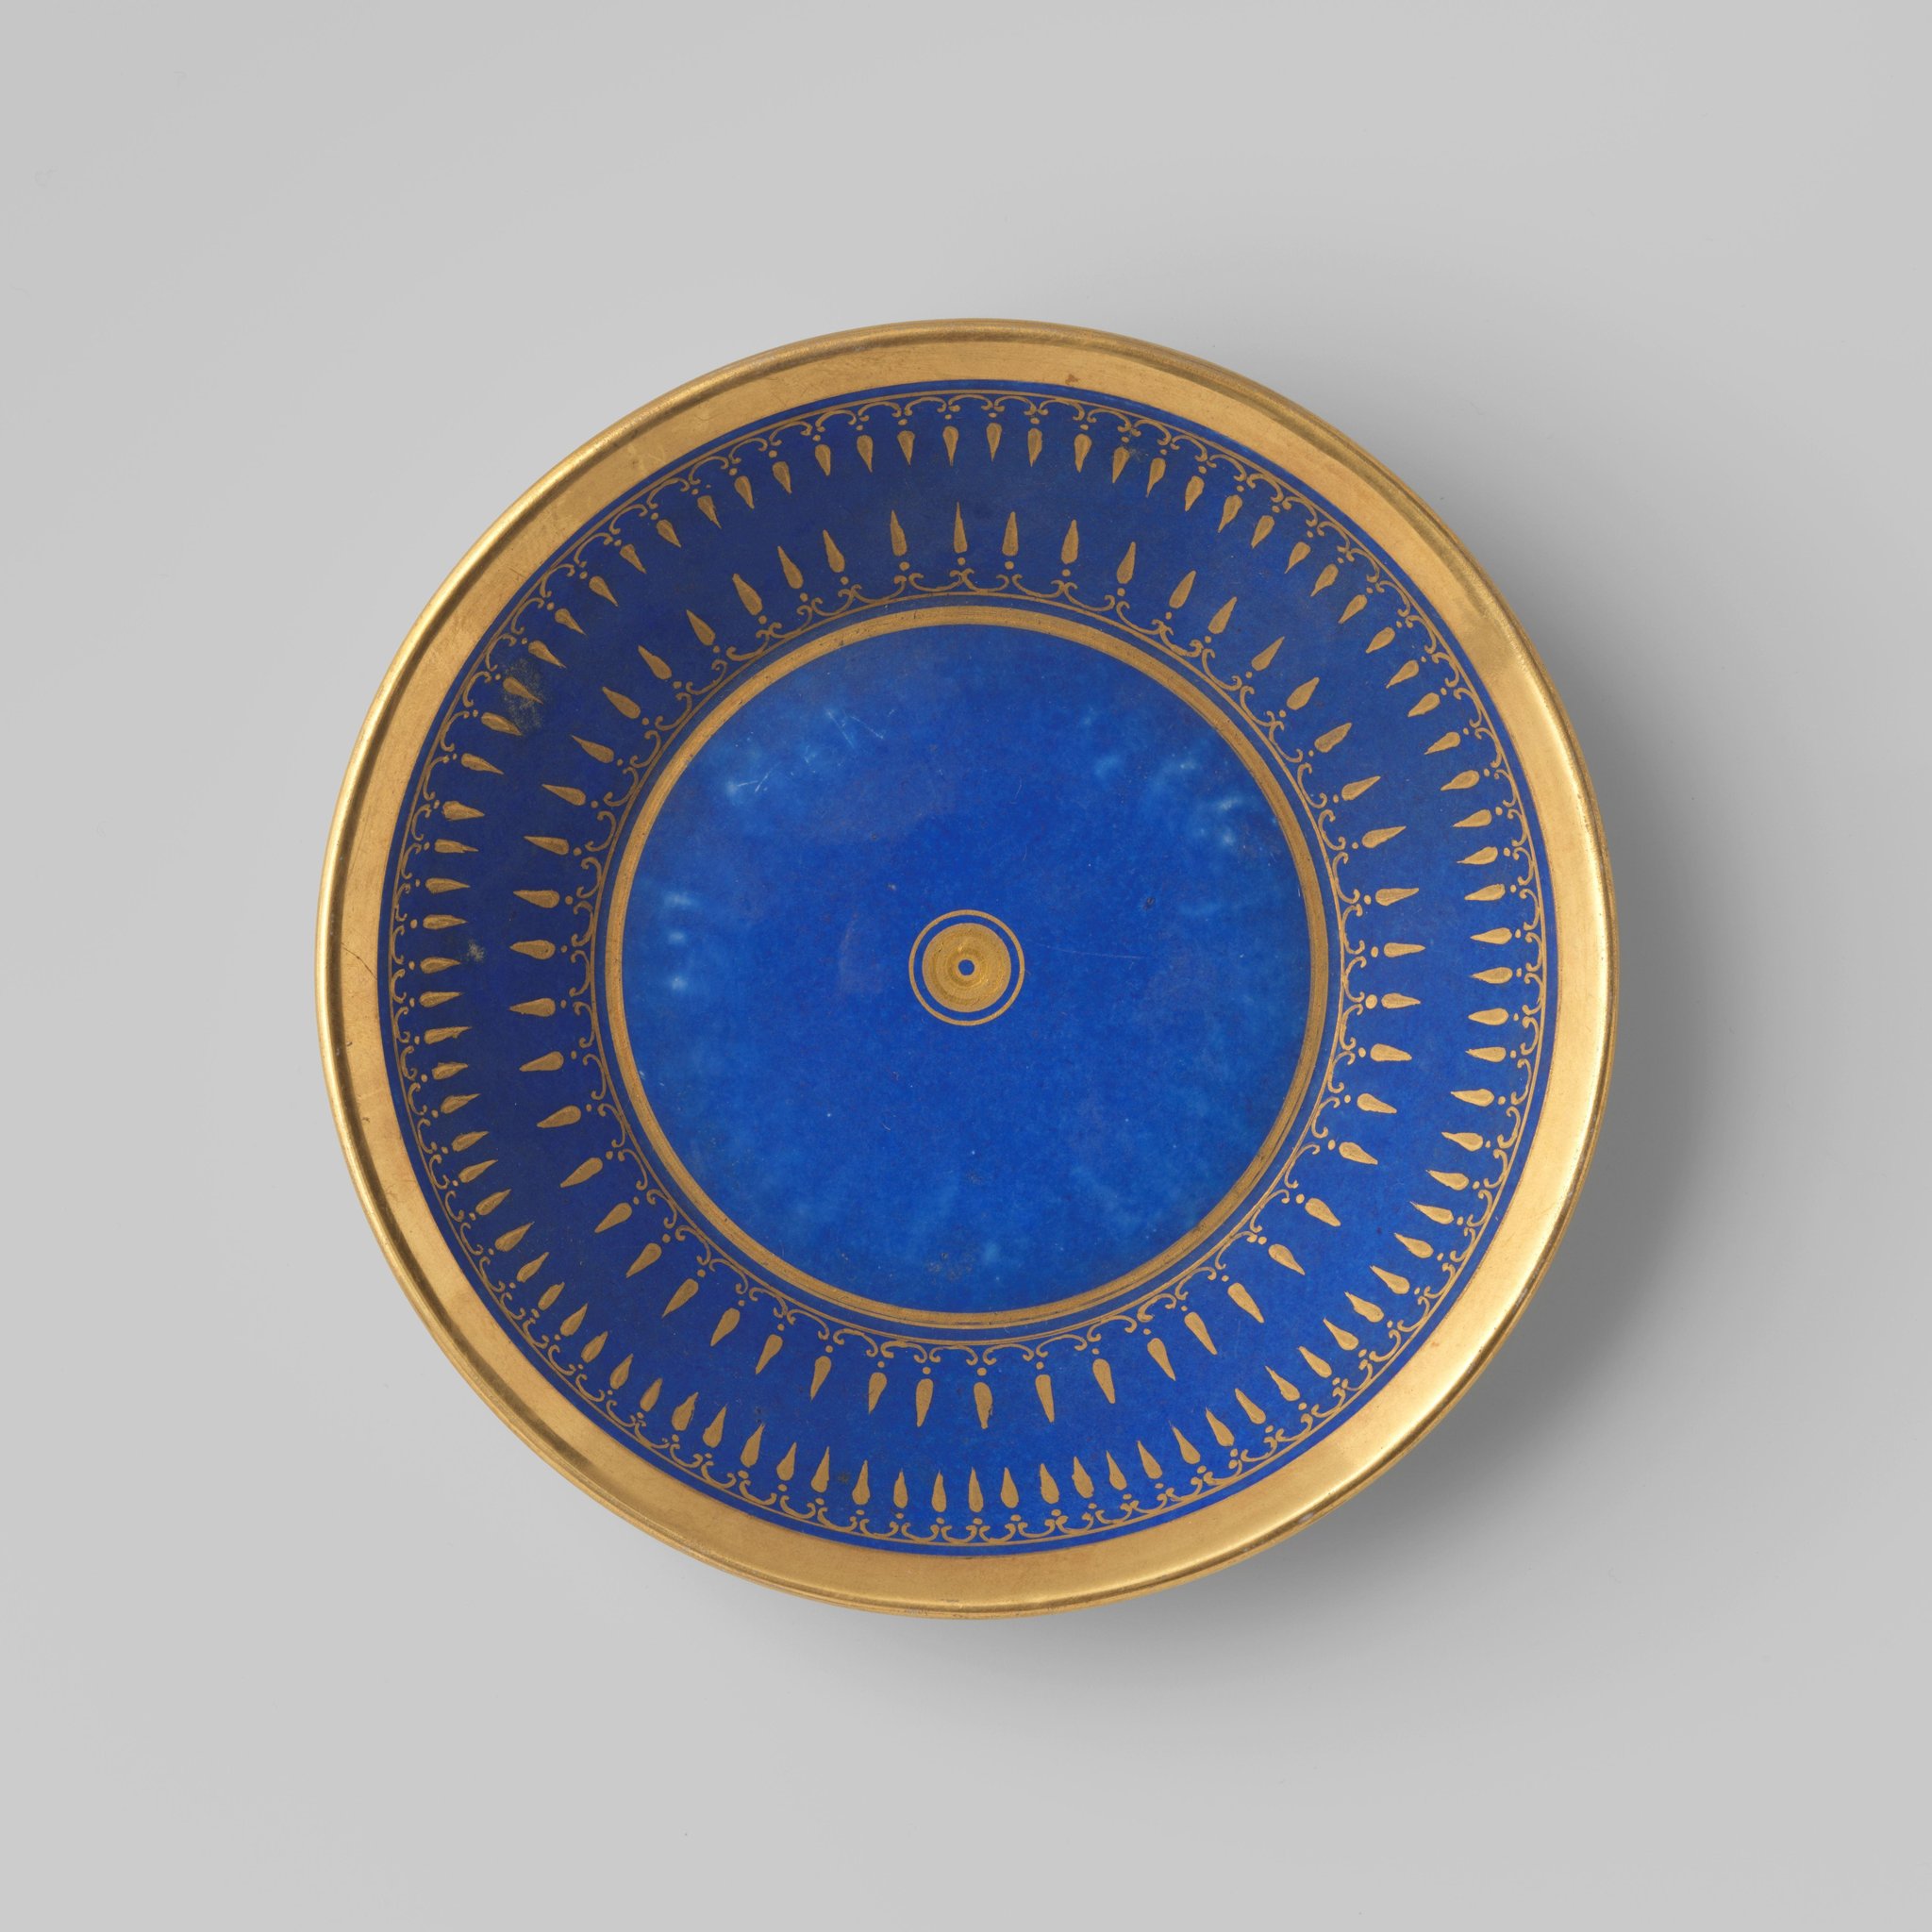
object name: platter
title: Saucer with ornamental borders on a blue ground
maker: Anonymous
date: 1800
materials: glaze, gold, paint, porcelain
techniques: firing, forming, gilding, relief, turning, vitrification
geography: france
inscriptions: mark: ‘91?’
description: Schotel van porselein met een rechte wand, beschilderd in blauw en goud. De voorzijde van de schotel is volledig bedekt met goud met daarop matblauw op het plat en de wand. Op het plat zijn hierin concentrische gouden cirkels gegrift en op de wand twee decoratieve banden. Op de buitenwand tweemaal een gouden lijn. Gemerkt op de onderzijde met 91[?].